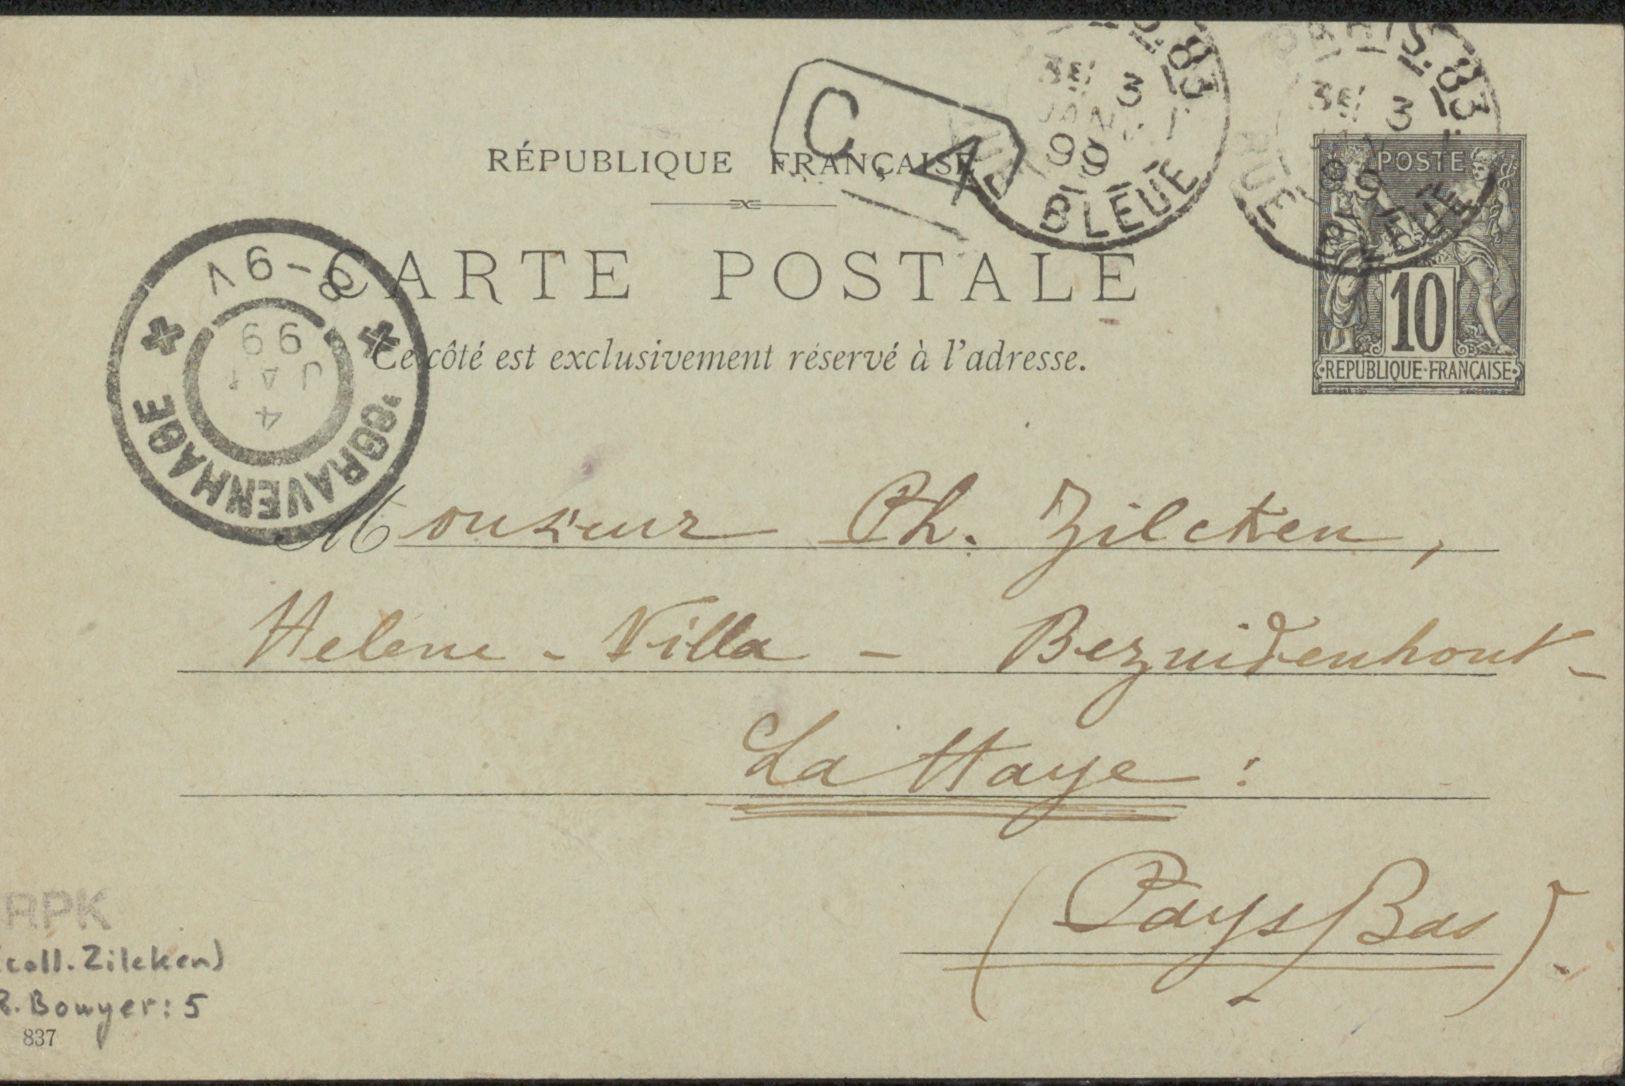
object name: postcard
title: Briefkaart aan Philip Zilcken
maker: louis-raymond bouyer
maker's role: redacteur, schrijver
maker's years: 1862-1935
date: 1899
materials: cardboard, ink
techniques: pen, writing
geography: paris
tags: the hague, painter, draughtsman, philip zilcken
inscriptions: collector's mark: ‘RPK’